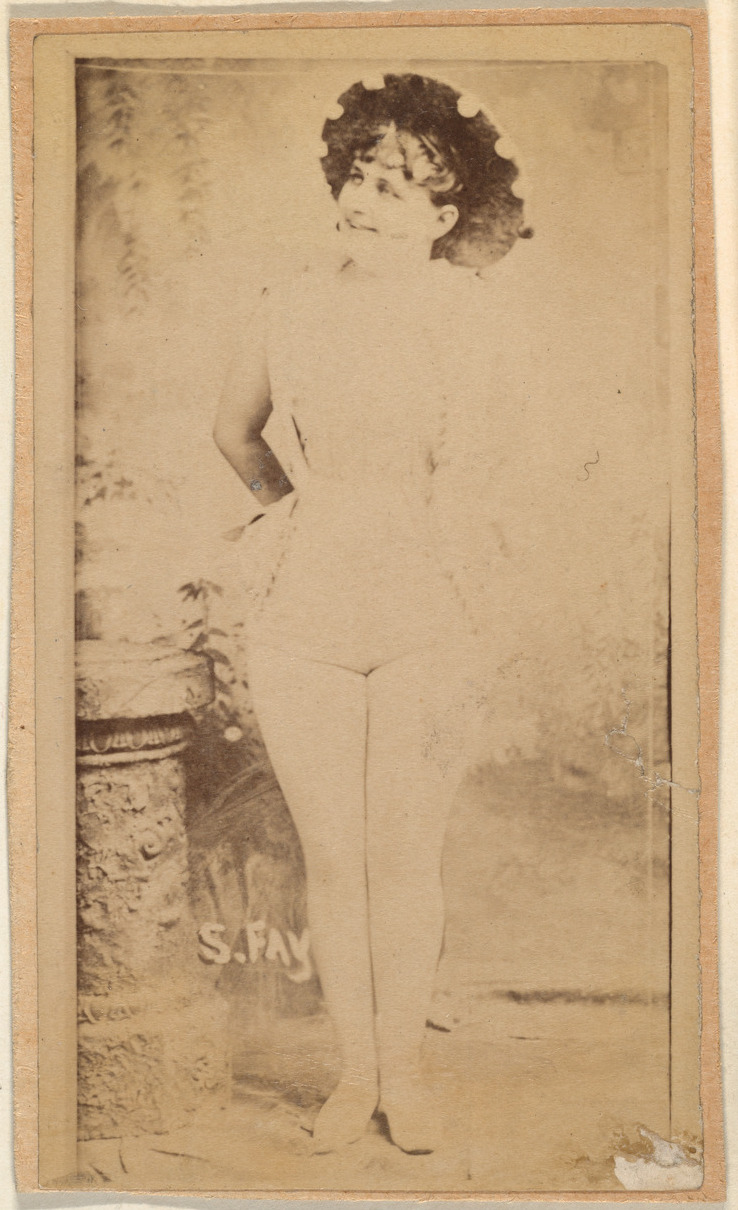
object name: photograph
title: Actress wearing brimmed hat with pompoms, from the Actresses series (N668)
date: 1888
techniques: albumen silver print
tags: portraits,women,actresses